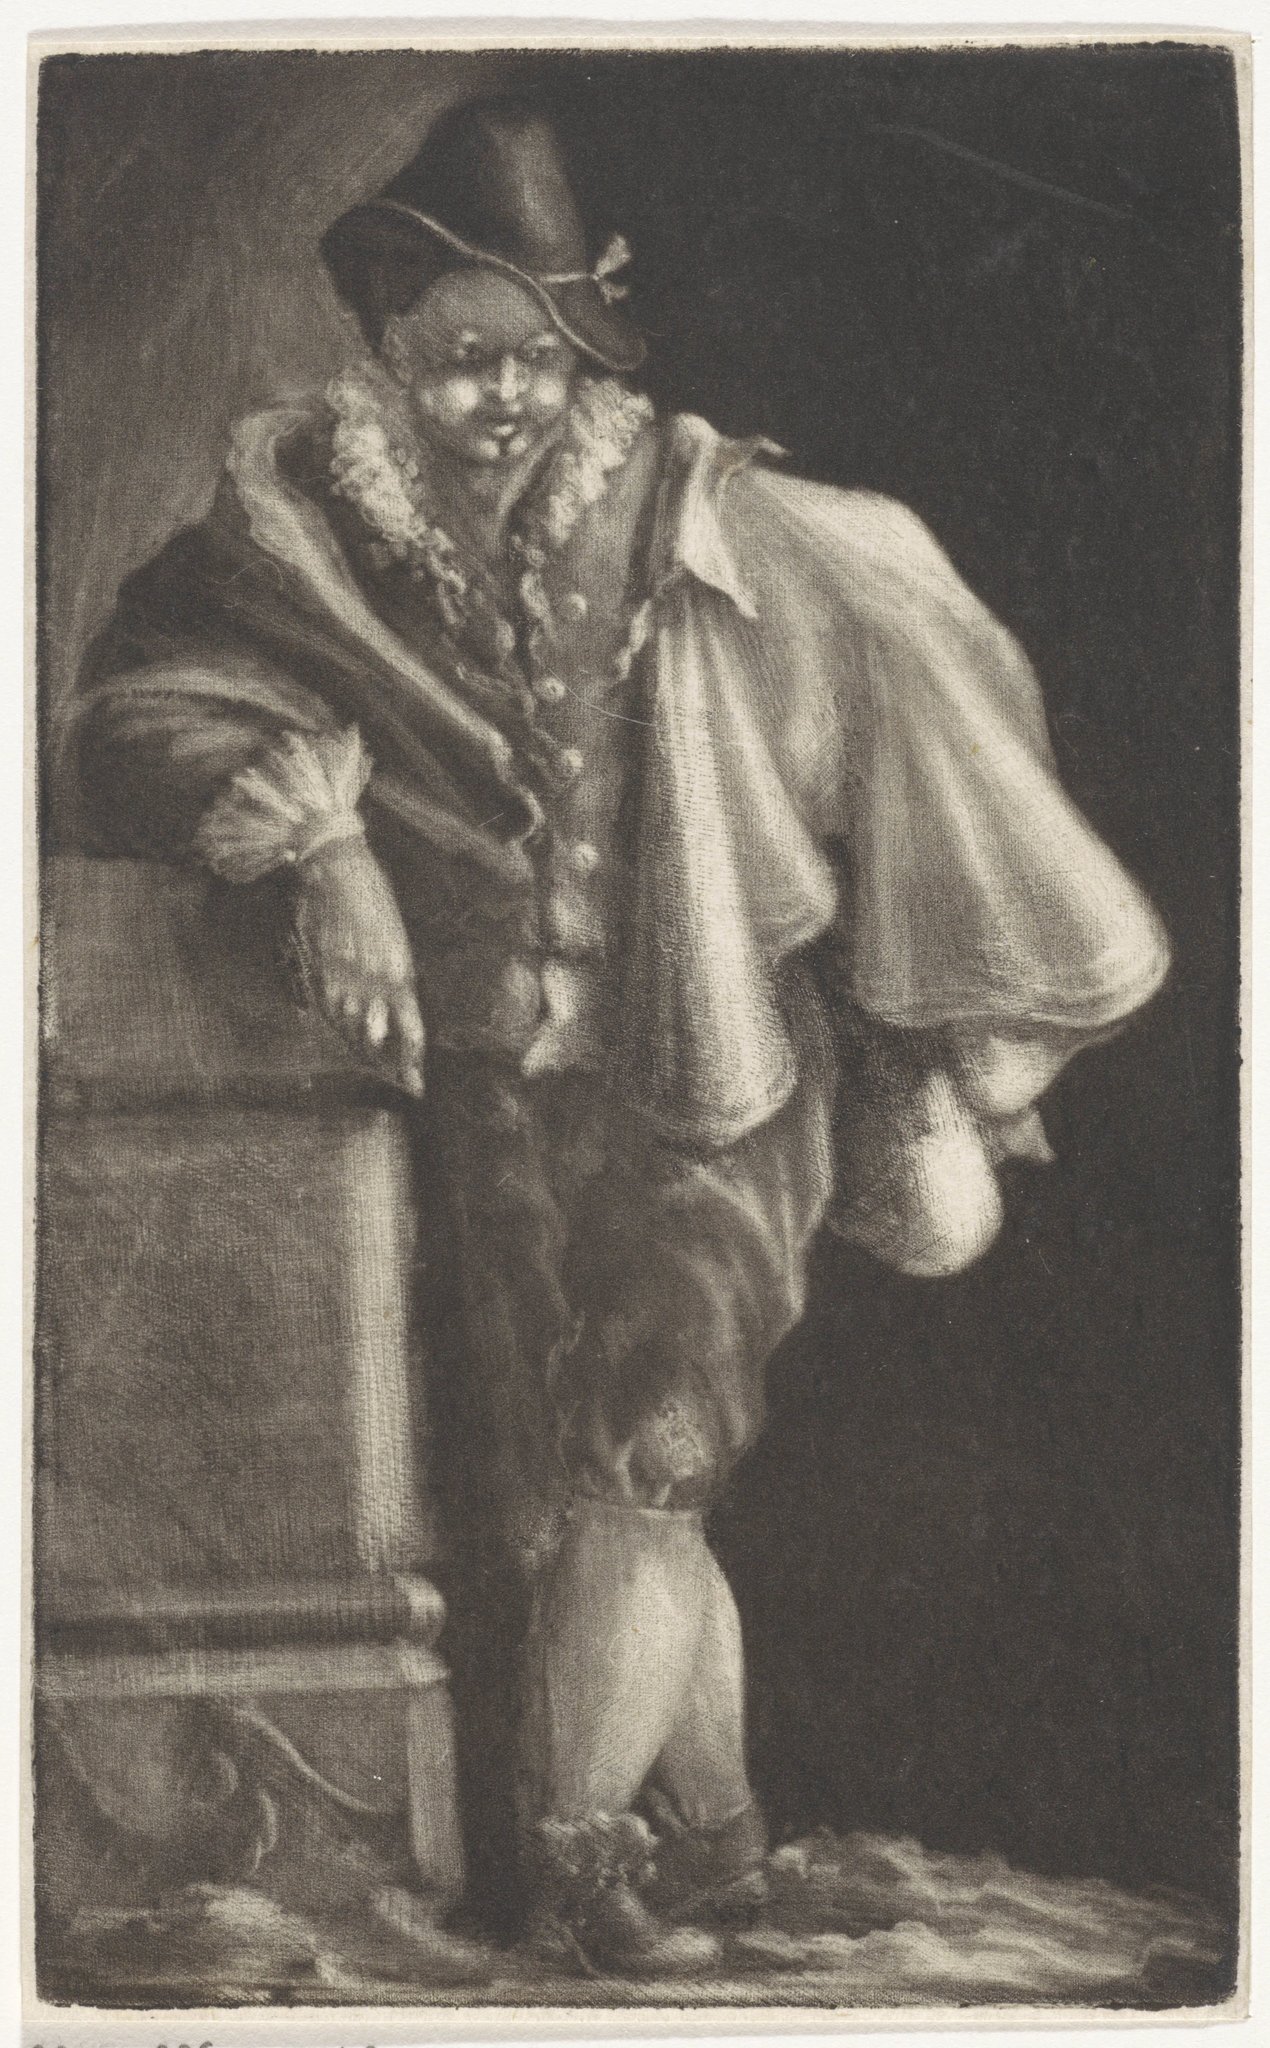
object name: print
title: Man leunt op een muur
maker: Anonymous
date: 1650-1800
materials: paper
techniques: mezzotint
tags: head-gear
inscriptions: collector's mark: Lugt 2228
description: Een man met hoed op en kort manteltje om leunt met zijn arm op de halfhoge muur waar hij naast staat.